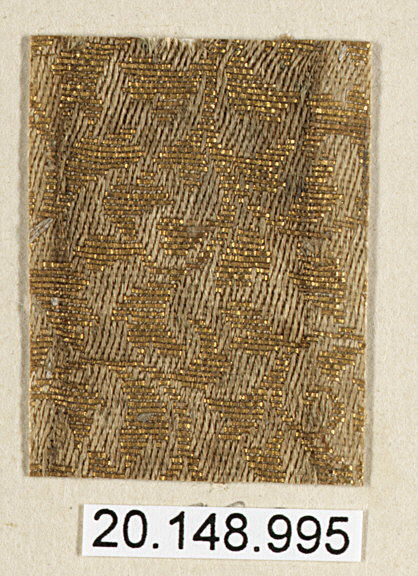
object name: piece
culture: japanese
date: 1701-1800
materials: silk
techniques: compound weave